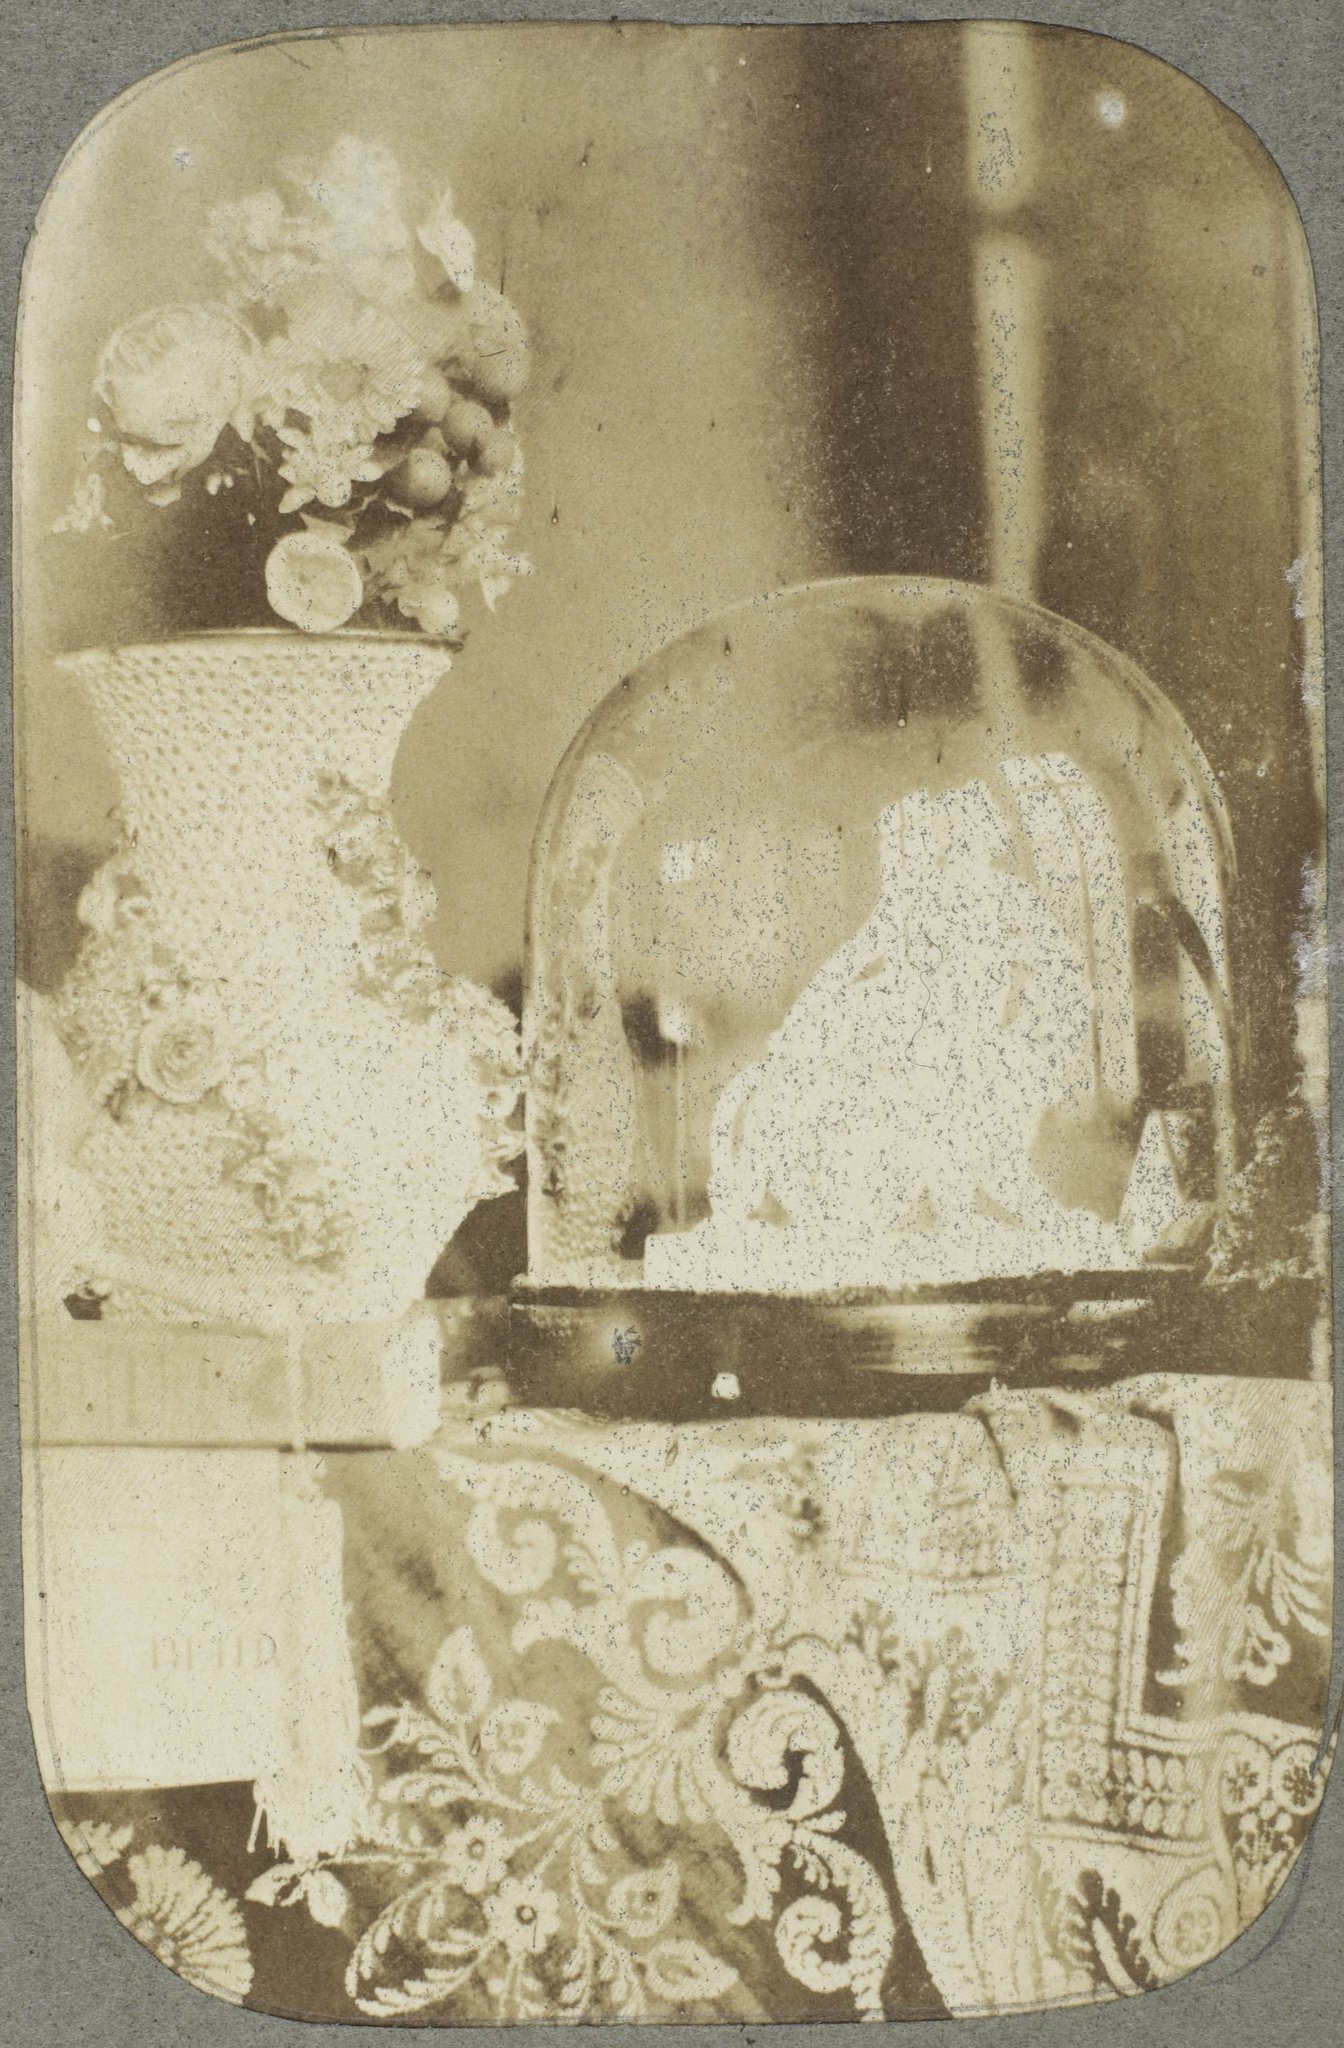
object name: photograph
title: Stilleven met een kleine kopie van 'Ariadne auf dem Panther', een 'Schneeball-vaas', bloemen en een boek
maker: eduard isaac asser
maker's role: amateurfotograaf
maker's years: 1809-1894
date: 1852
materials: cardboard, paper, photographic support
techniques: salted paper print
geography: amsterdam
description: Stilleven met een kleine kopie van Danneckers 'Ariadne auf dem Panther' onder een stolp, een Meissen 'Schneeball-vaas', bloemen en een boek